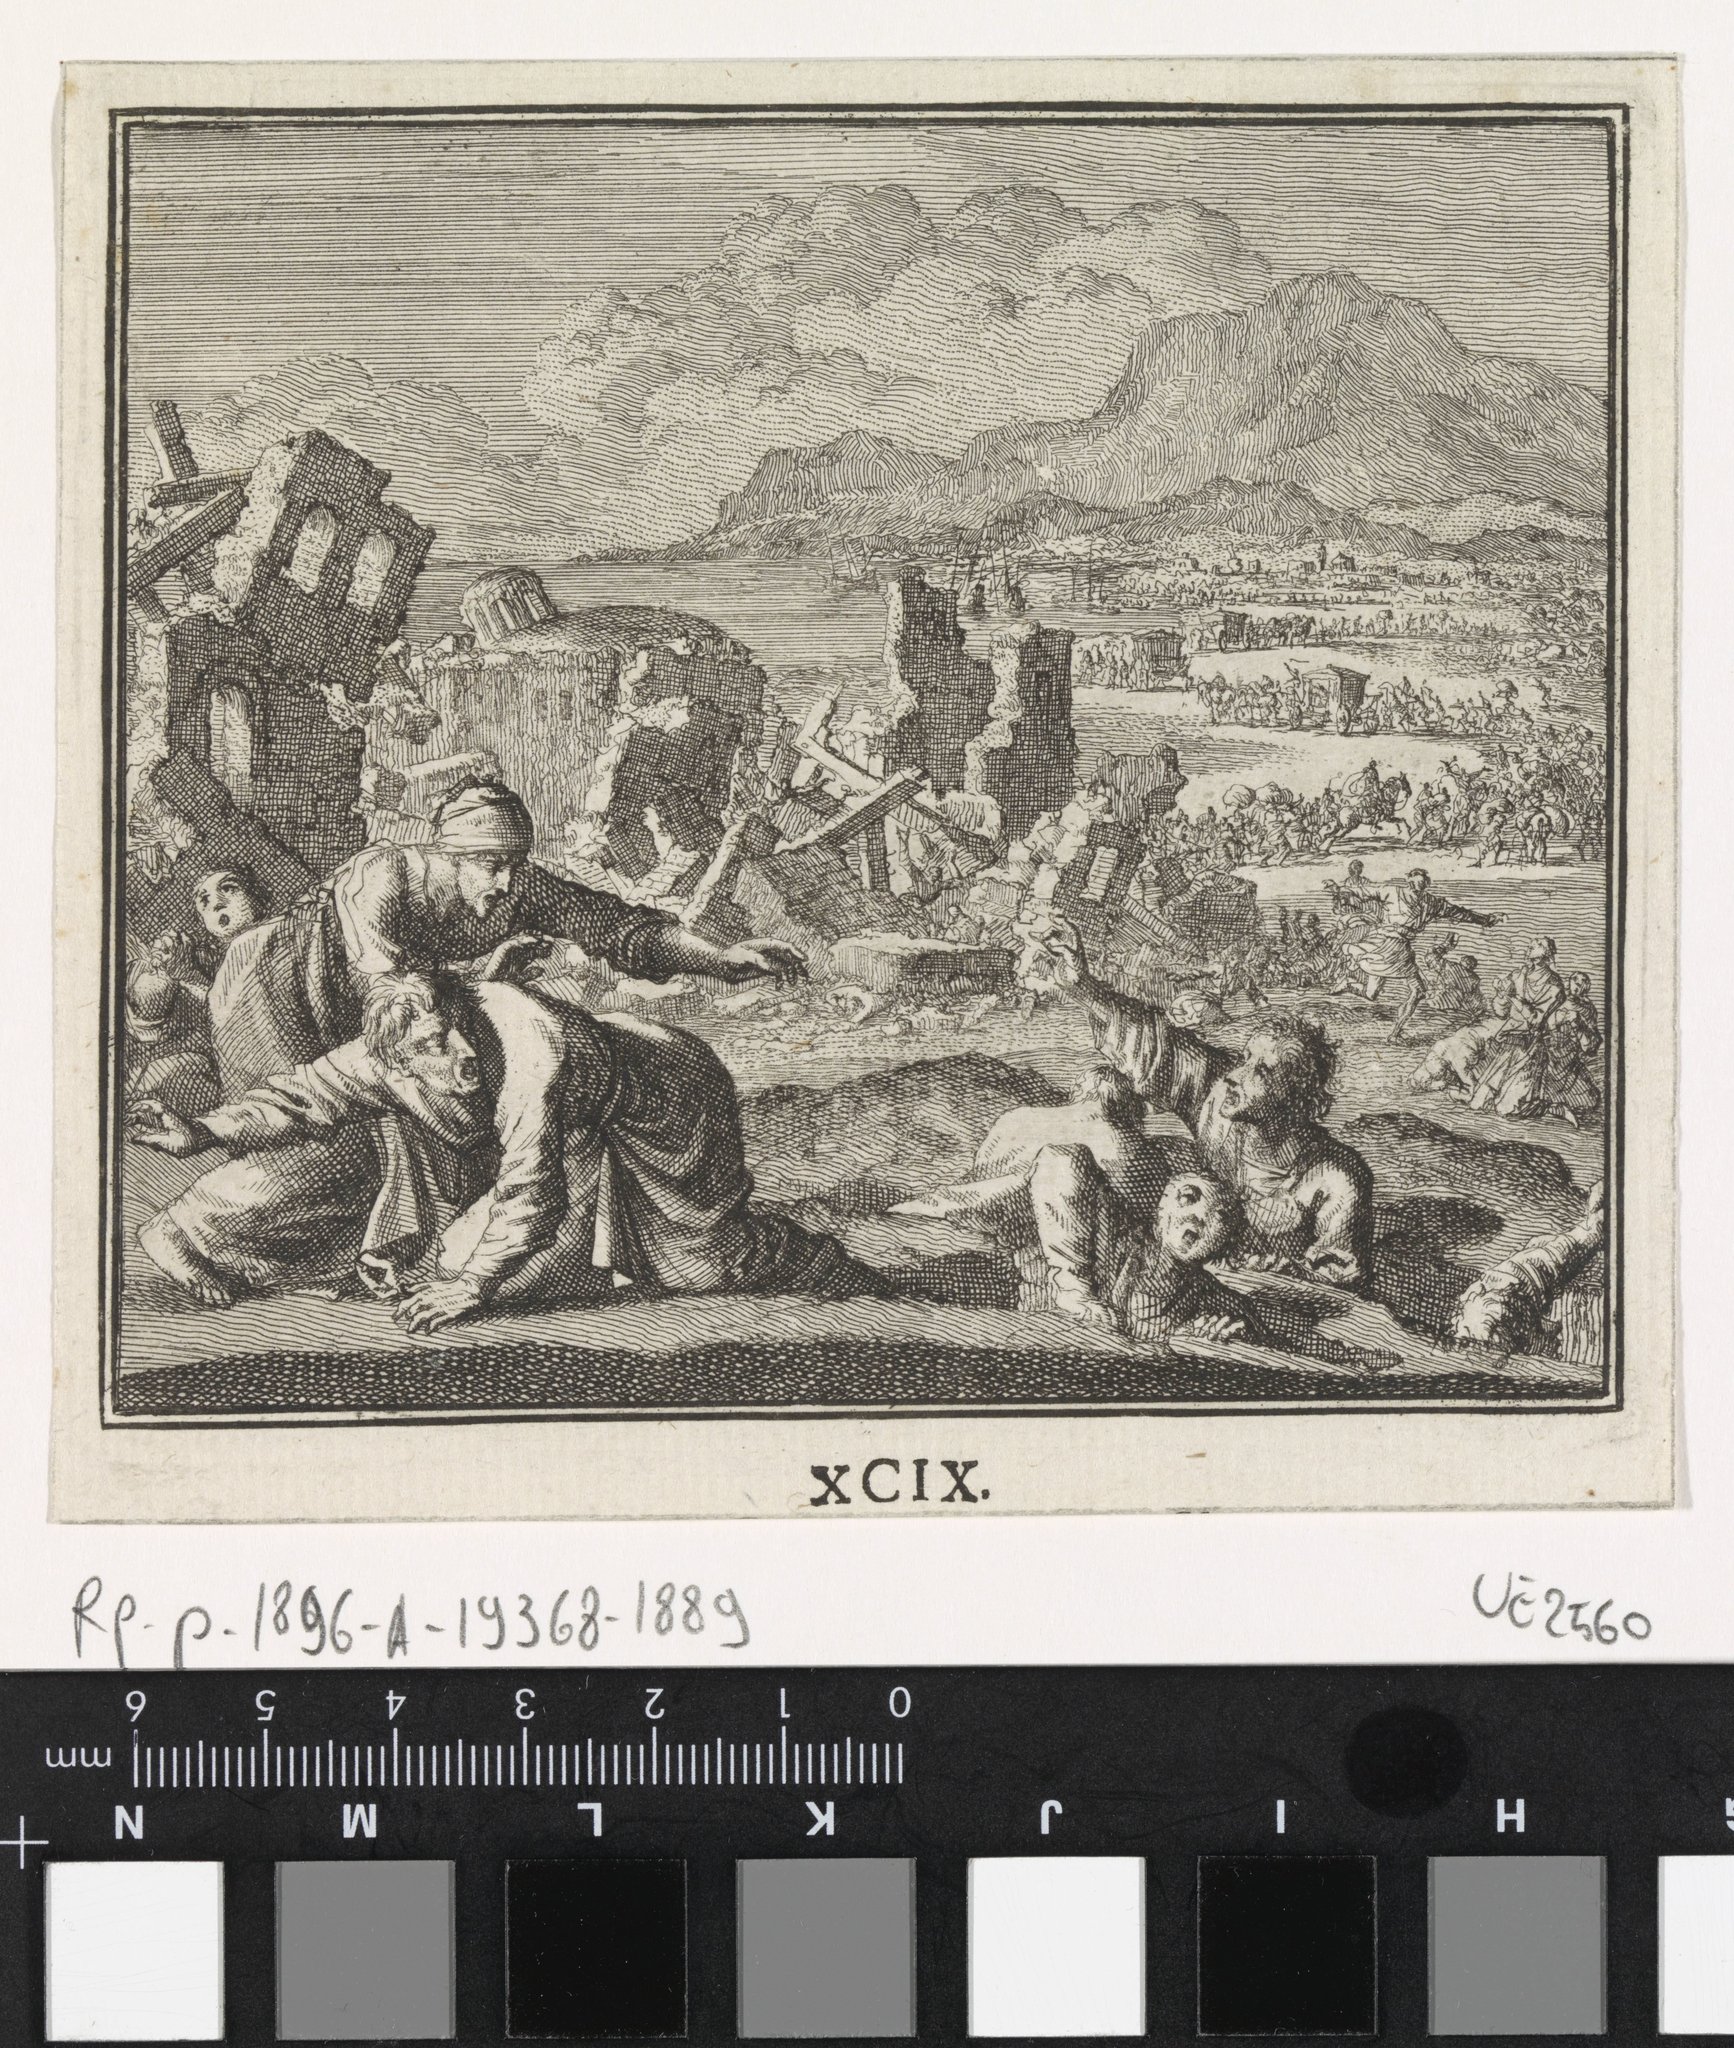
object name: book illustration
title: Embleem: aardbeving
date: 1695-1705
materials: paper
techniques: etching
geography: amsterdam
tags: collapsing building, earthquake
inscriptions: collector's mark: Lugt 2228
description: Boekillustratie voor Weigel, Christoph. Ethica Naturalis seu Documenta Moralia e Variis rerum Naturalium proprietatibus Virtutum Vitiorumq symbolicis imaginibus collecta. Neurenberg: Christoph Weigel: c. 1700.